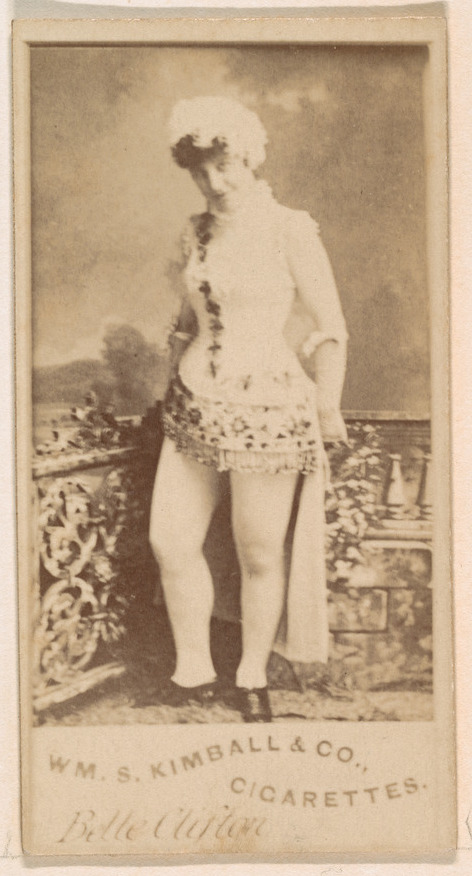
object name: photograph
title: Belle Clifton, from the Actresses series (N203) issued by Wm. S. Kimball & Co.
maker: william s. kimball & company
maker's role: publisher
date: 1889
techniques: color lithograph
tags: portraits,women,actresses